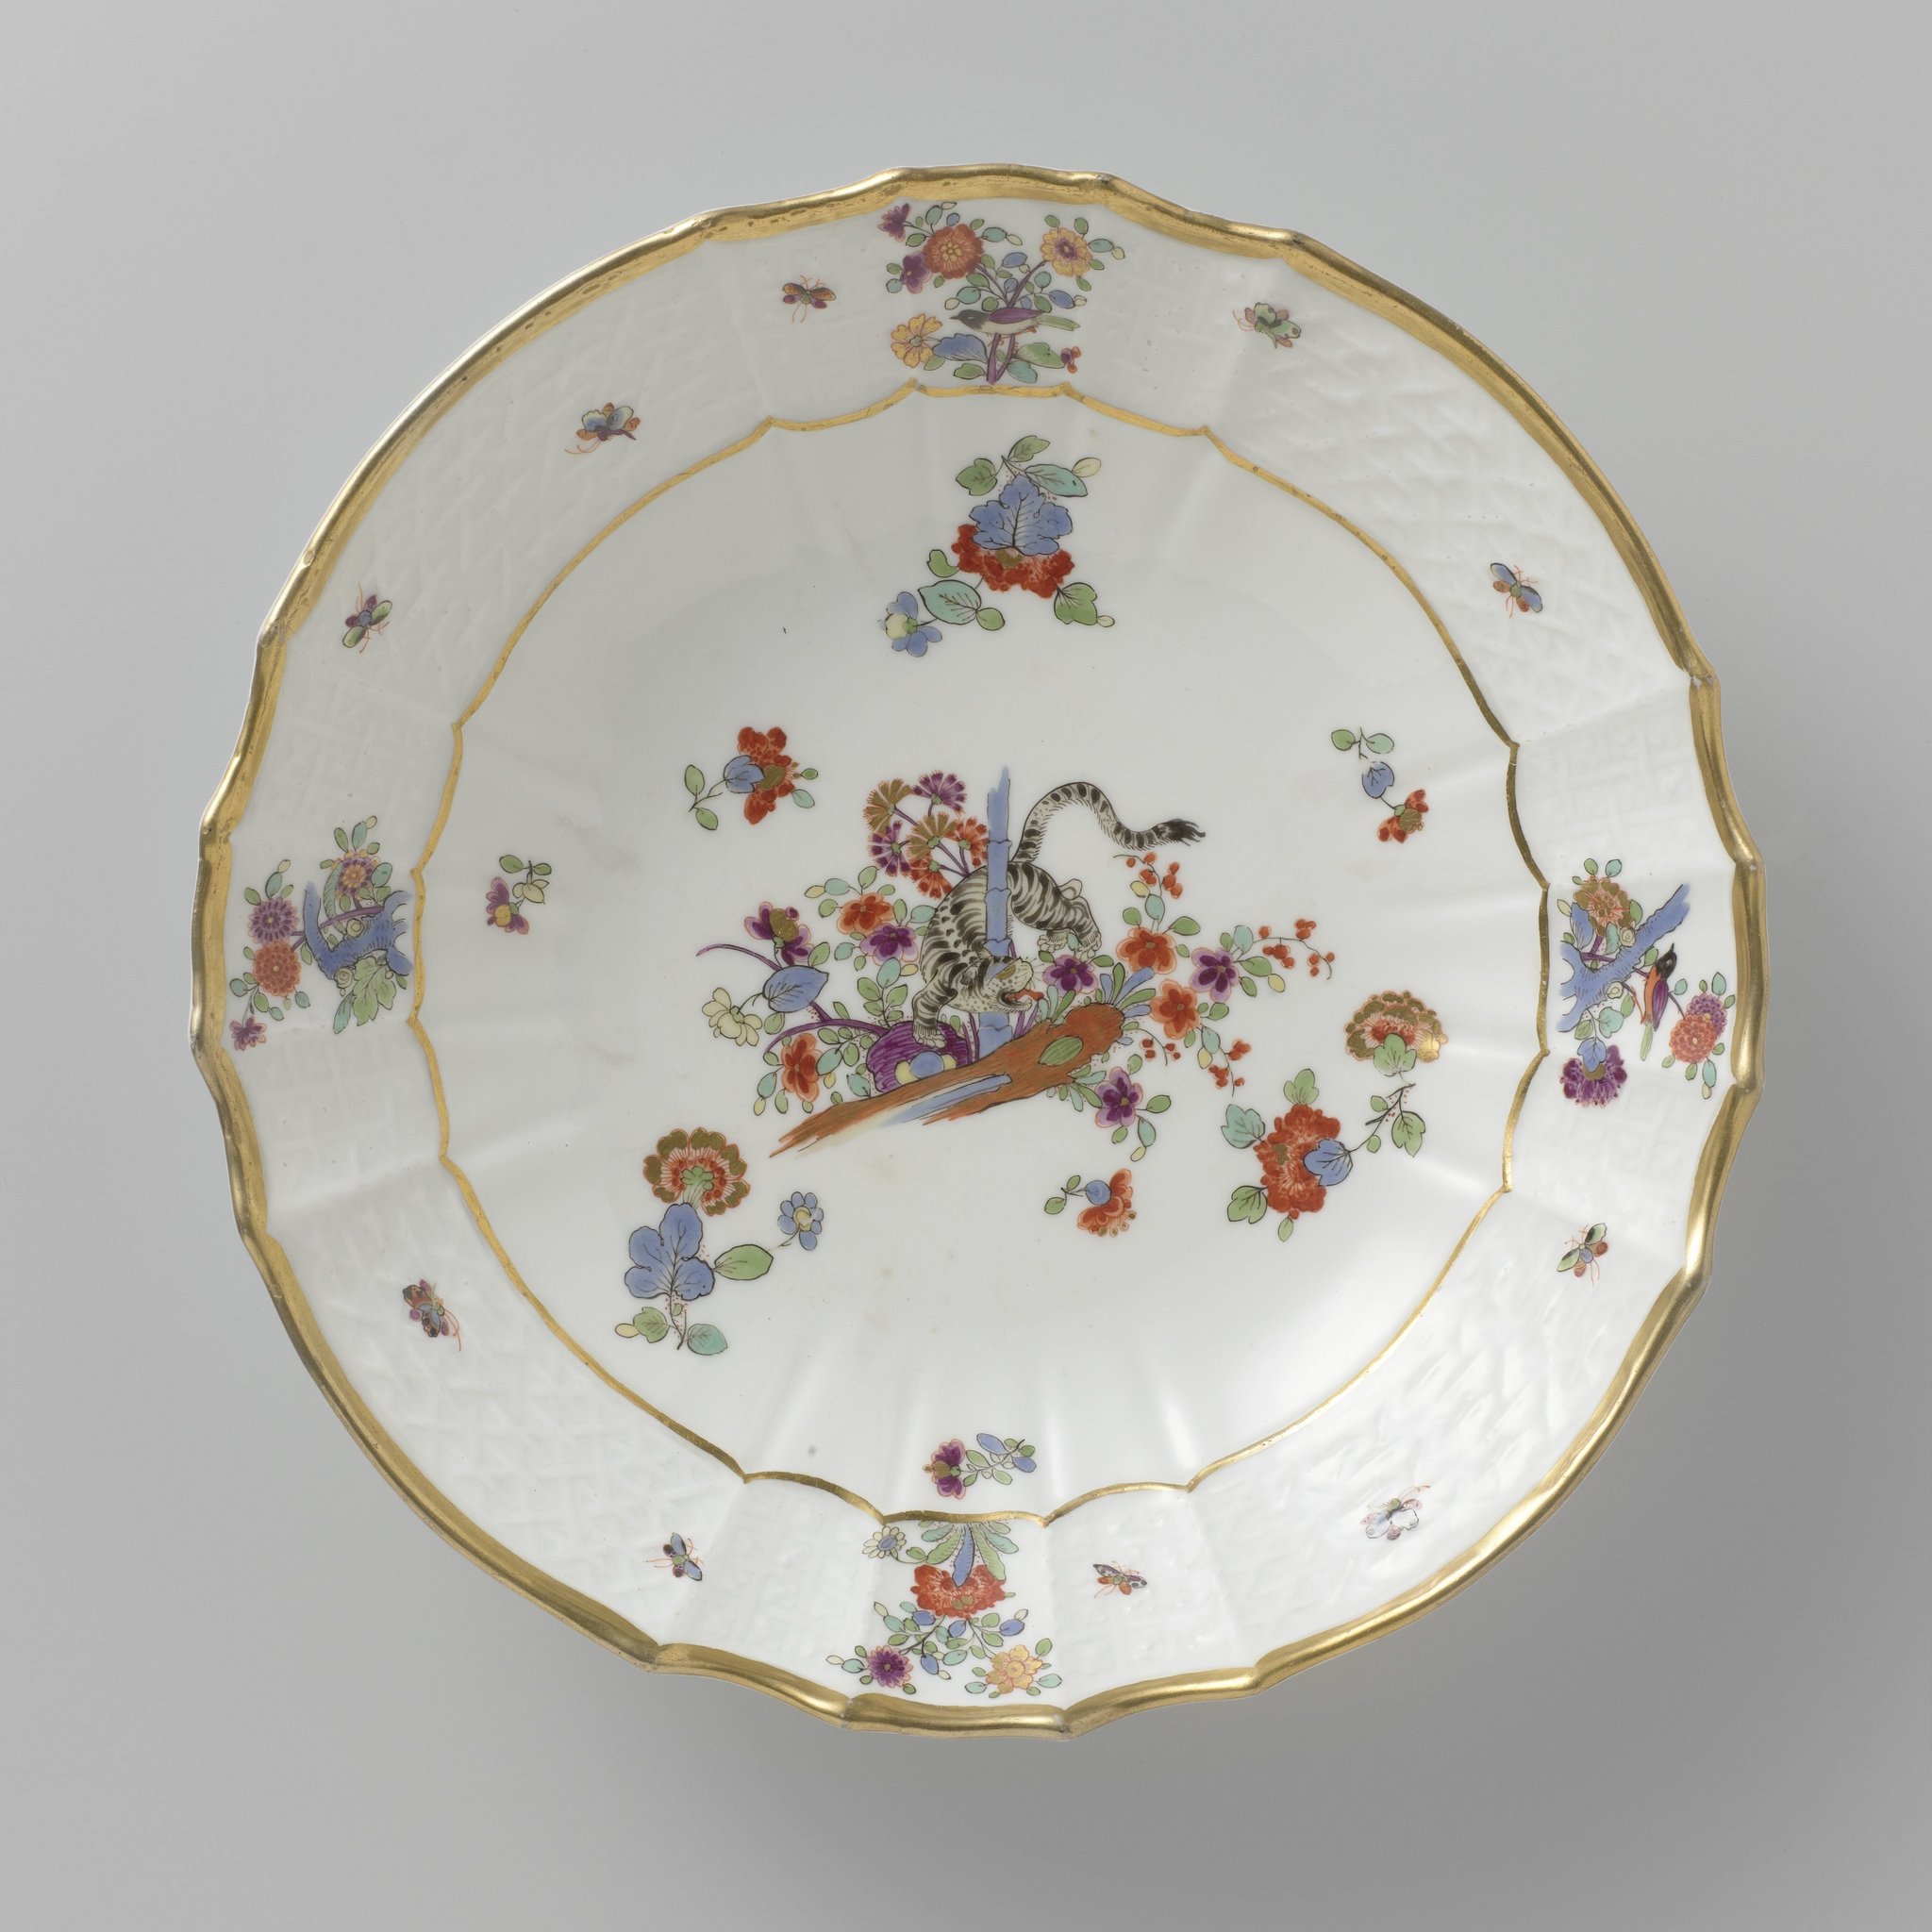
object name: platter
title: Schotel, veelkleurig beschilderd met een Kakiemon-decor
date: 1740-1745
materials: porcelain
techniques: painted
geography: meissen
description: Ronde schotel van beschilderd porselein. De schotel heeft een geribde en geschulpte rand. De schotel is beschilderd met een tijger om een bamboestengel, gestrooide Indianische Blumen, vlinders en takken met vogels. De rand is versierd met het 'Altbrandenstein'-patroon. De schotel is gemerkt.